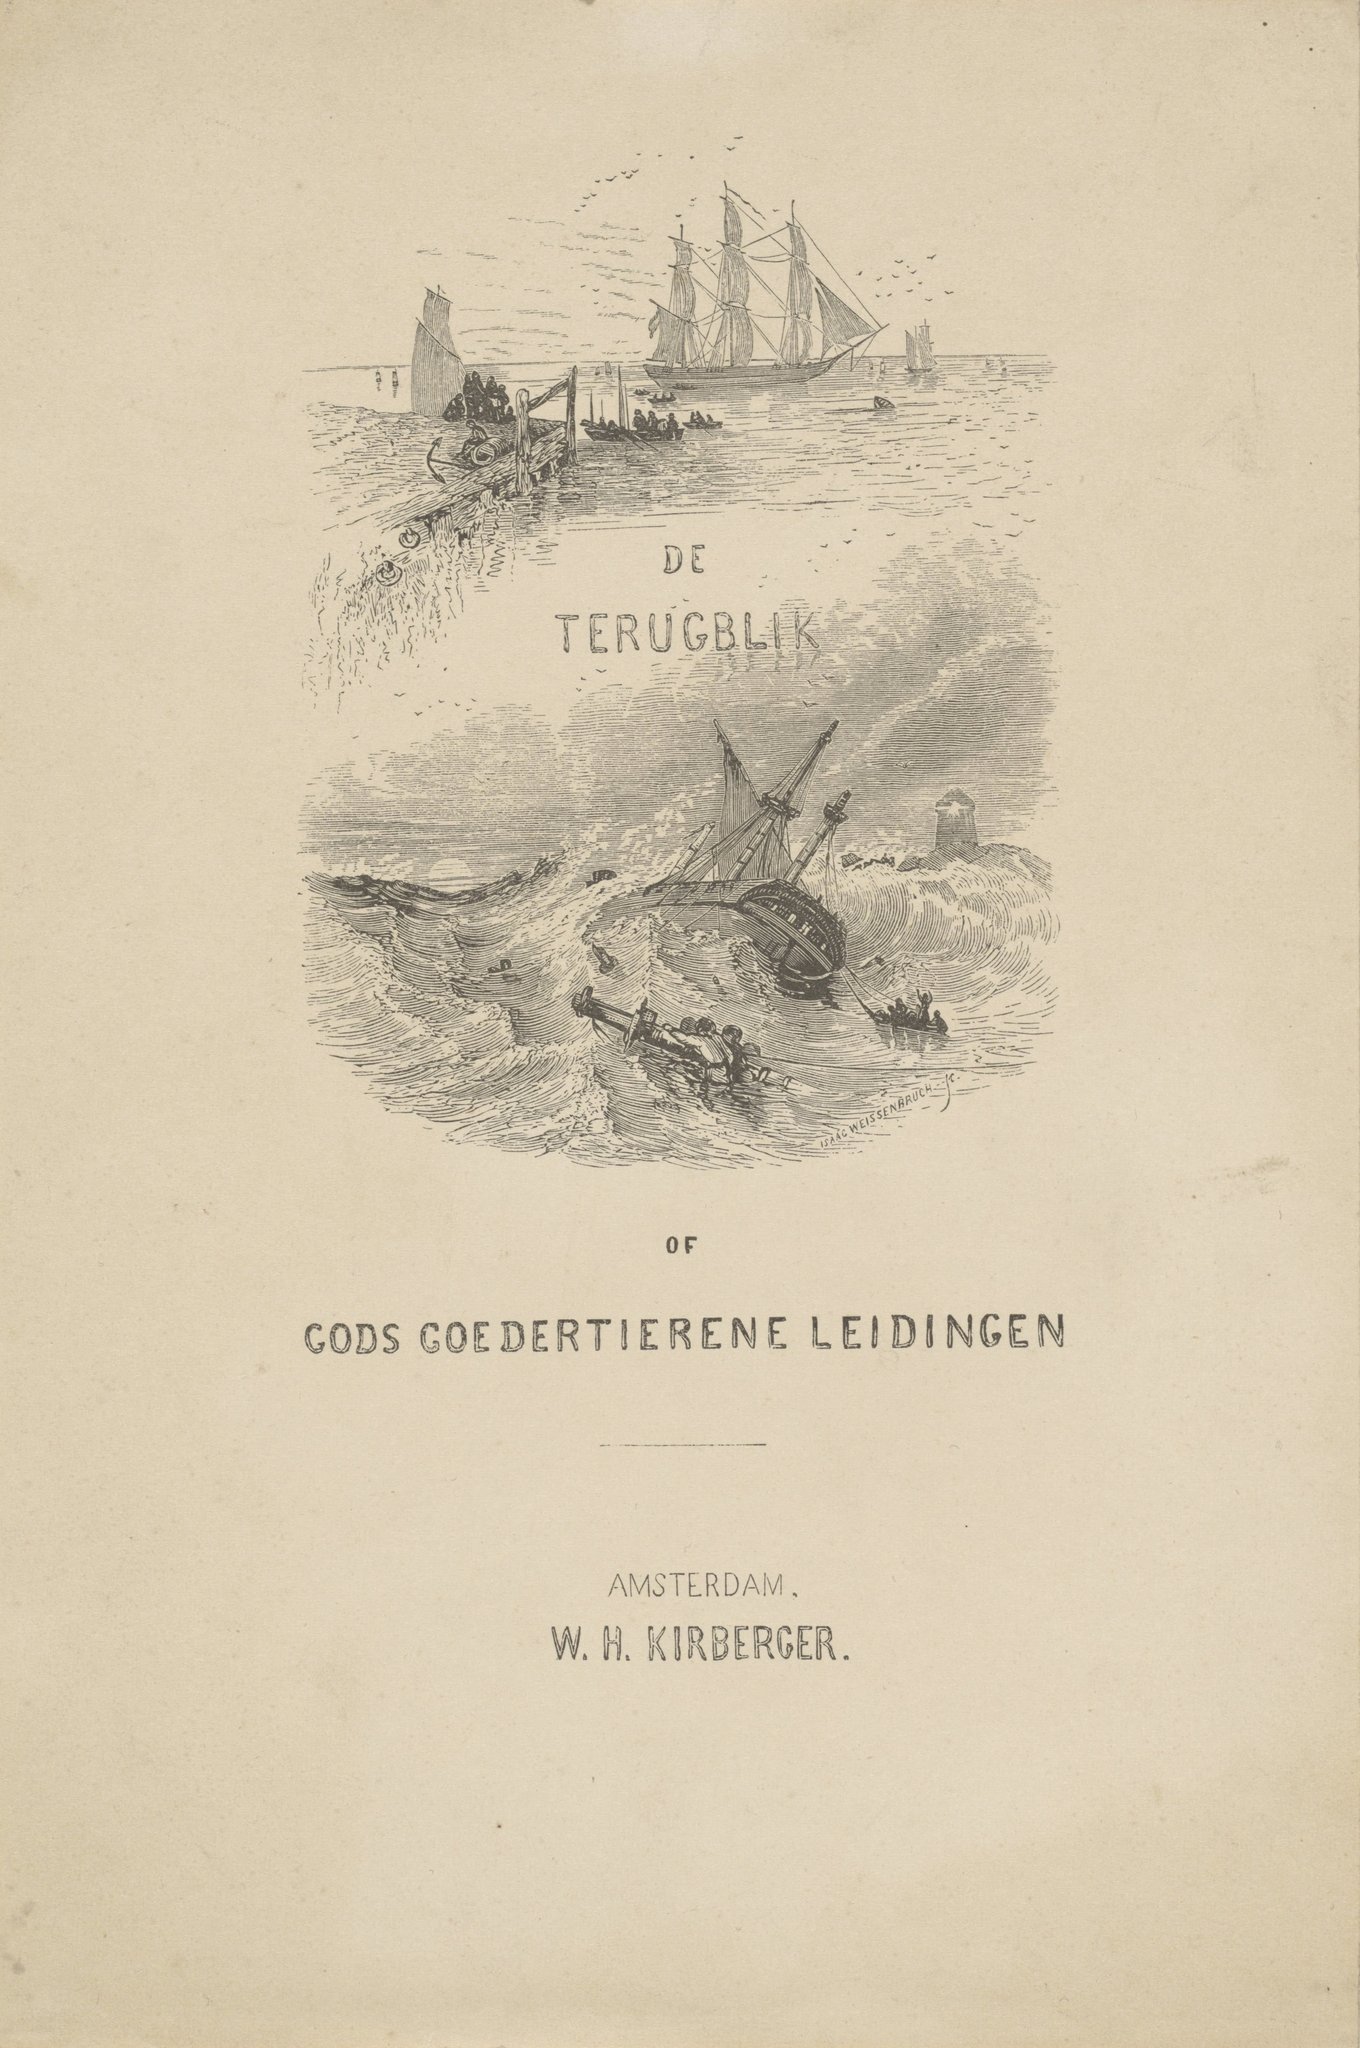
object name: titelblad, titelpagina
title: Titelpagina voor: Richard Marks, De terugblik of Gods goedertierene leidingen, 1854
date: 1854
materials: paper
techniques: engraving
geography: netherlands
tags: sailing-ship, sailing-boat, storm at sea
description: Boven een groep figuren in een boot varend van de kade naar een schip om daarmee te vertrekken. Onder een schip in de storm en figuren in de zee vasthoudend aan drijfhout.